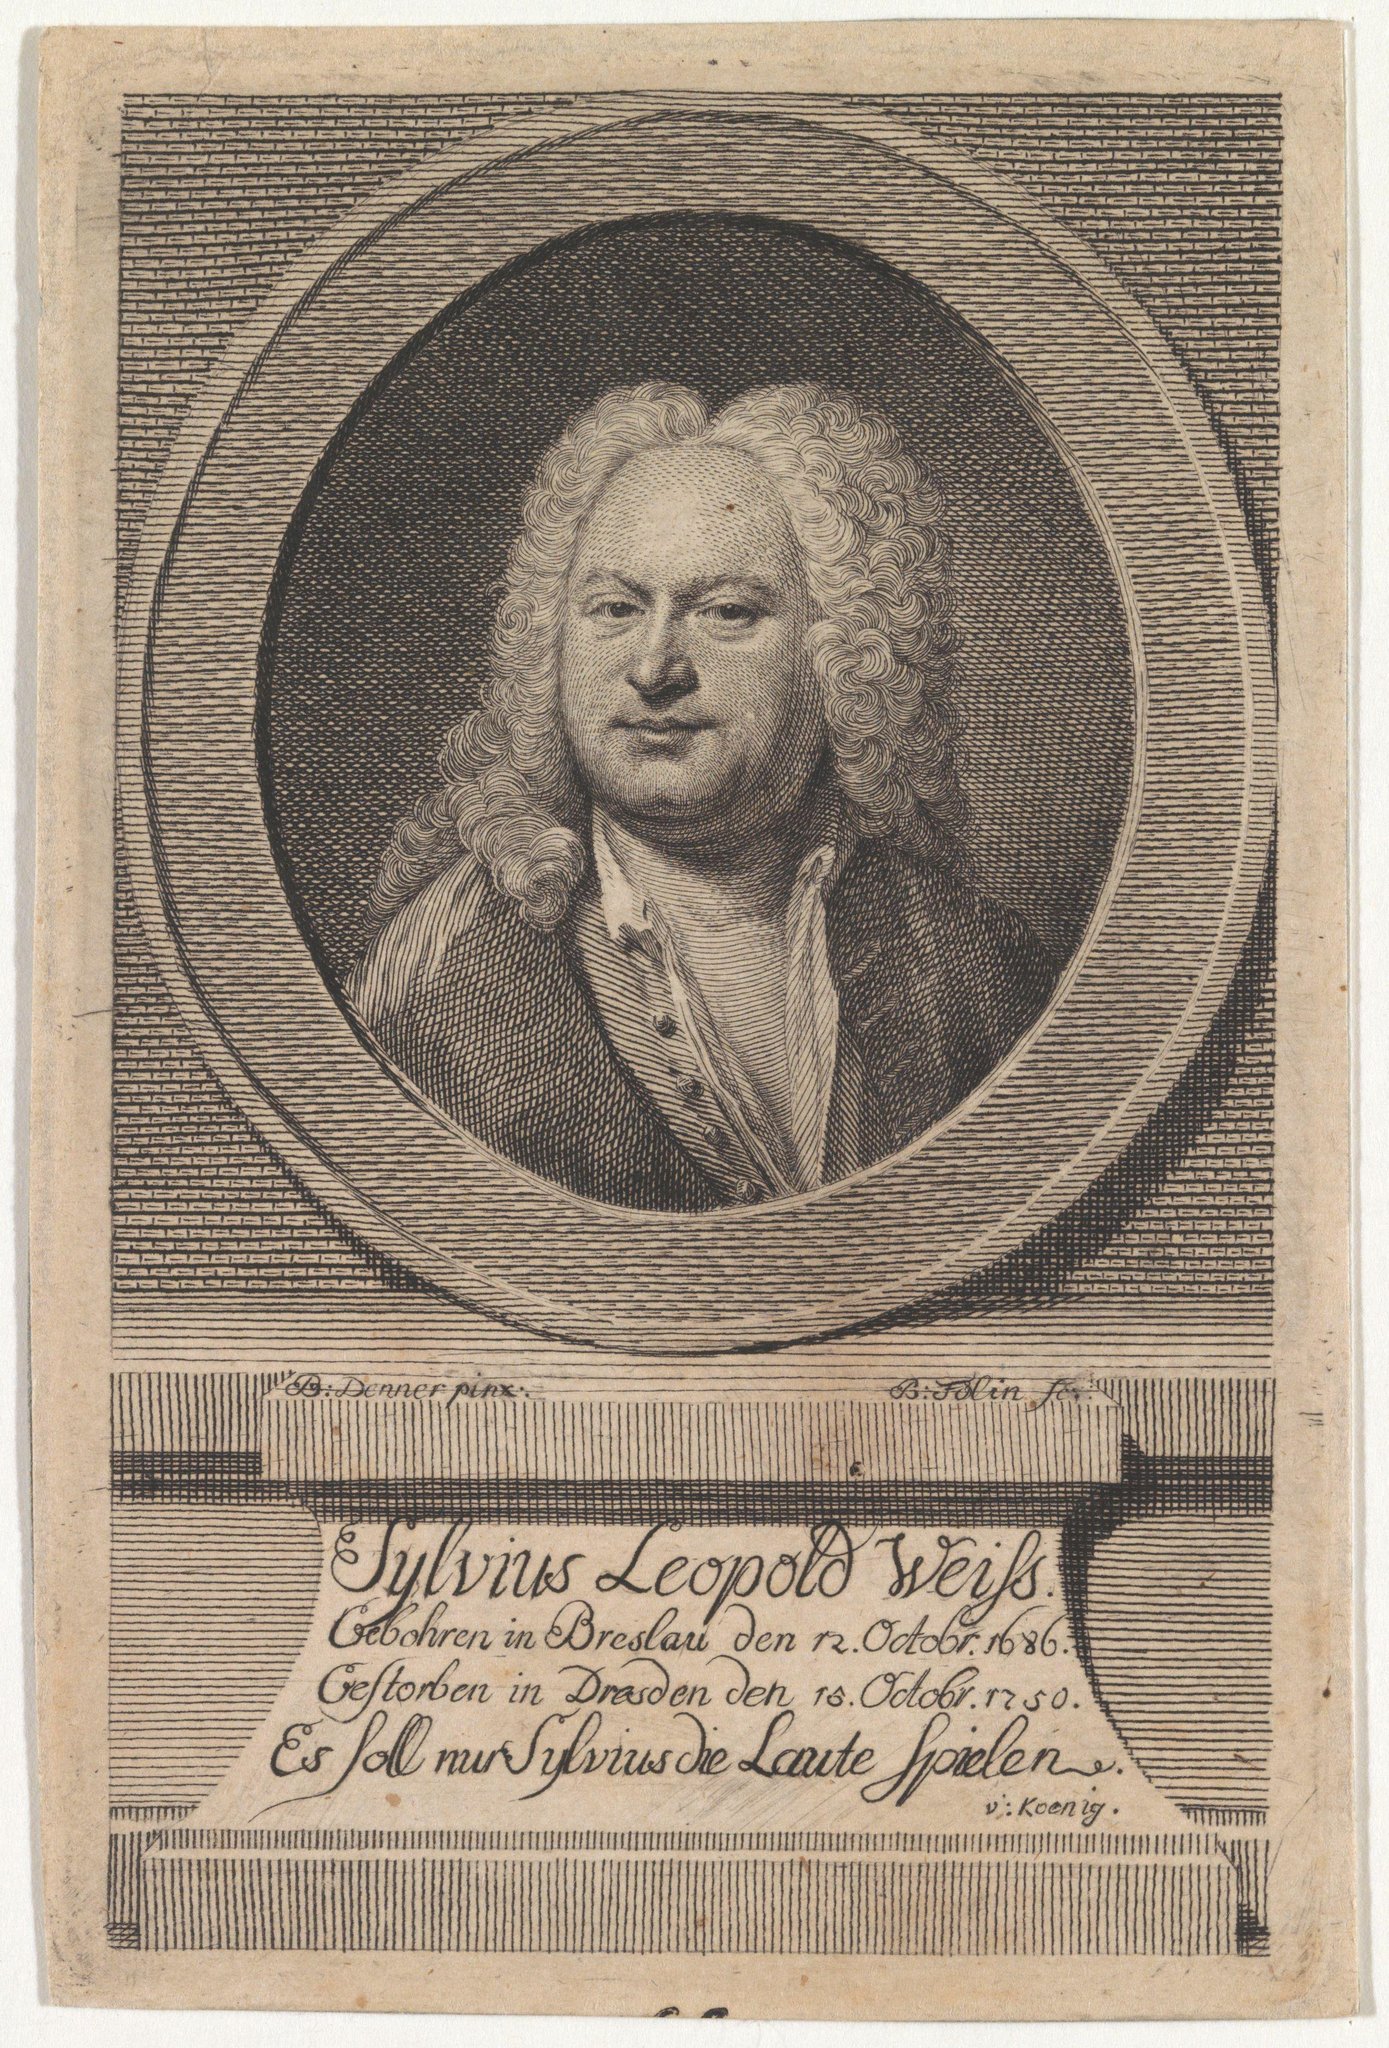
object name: print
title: Portret van componist en luitspeler Sylvius Leopold Weiss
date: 1765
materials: paper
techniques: engraving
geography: italy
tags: musician, historical persons, portrait of a musician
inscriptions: number: ‘167’, collector's mark: Lugt 1337, collector's mark: Lugt 2228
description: Prent waarschijnlijk uit: Neue Bibliothek der schönen Wissenschaften und der freyen Künste. Leipzig: Johann Gottfried Dyck, 1765.